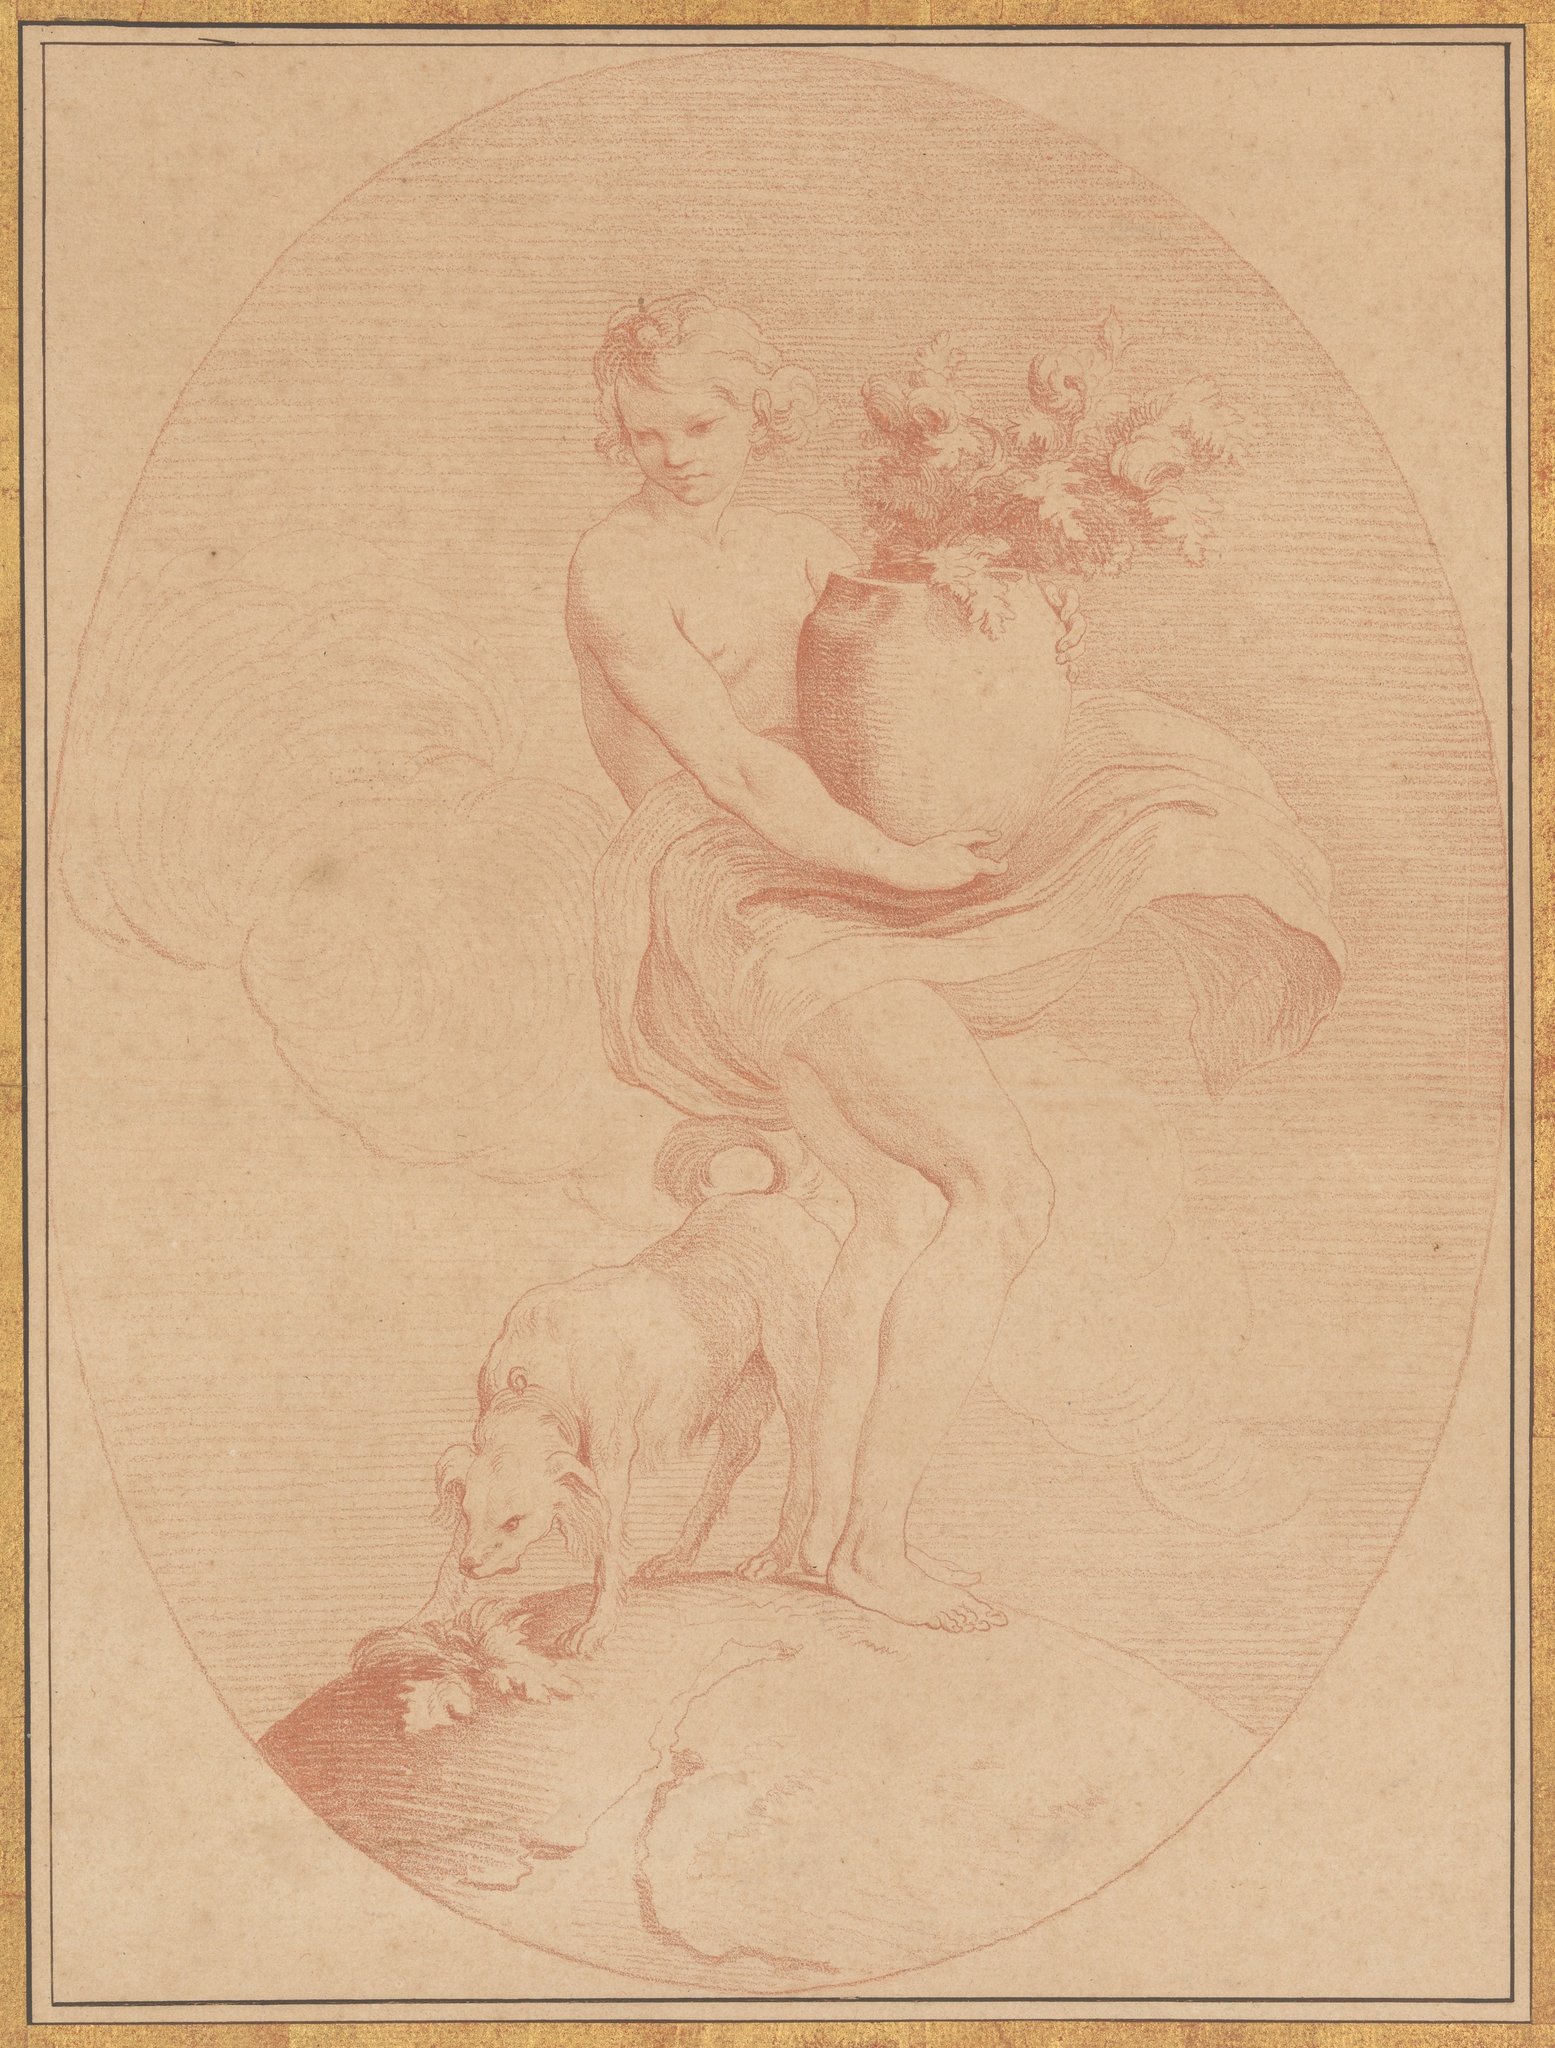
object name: drawing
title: The Sense of Smell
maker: edme bouchardon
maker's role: artist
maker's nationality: french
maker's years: 1698-1762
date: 1700-1770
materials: chalk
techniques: printmaking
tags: men,dogs,vases